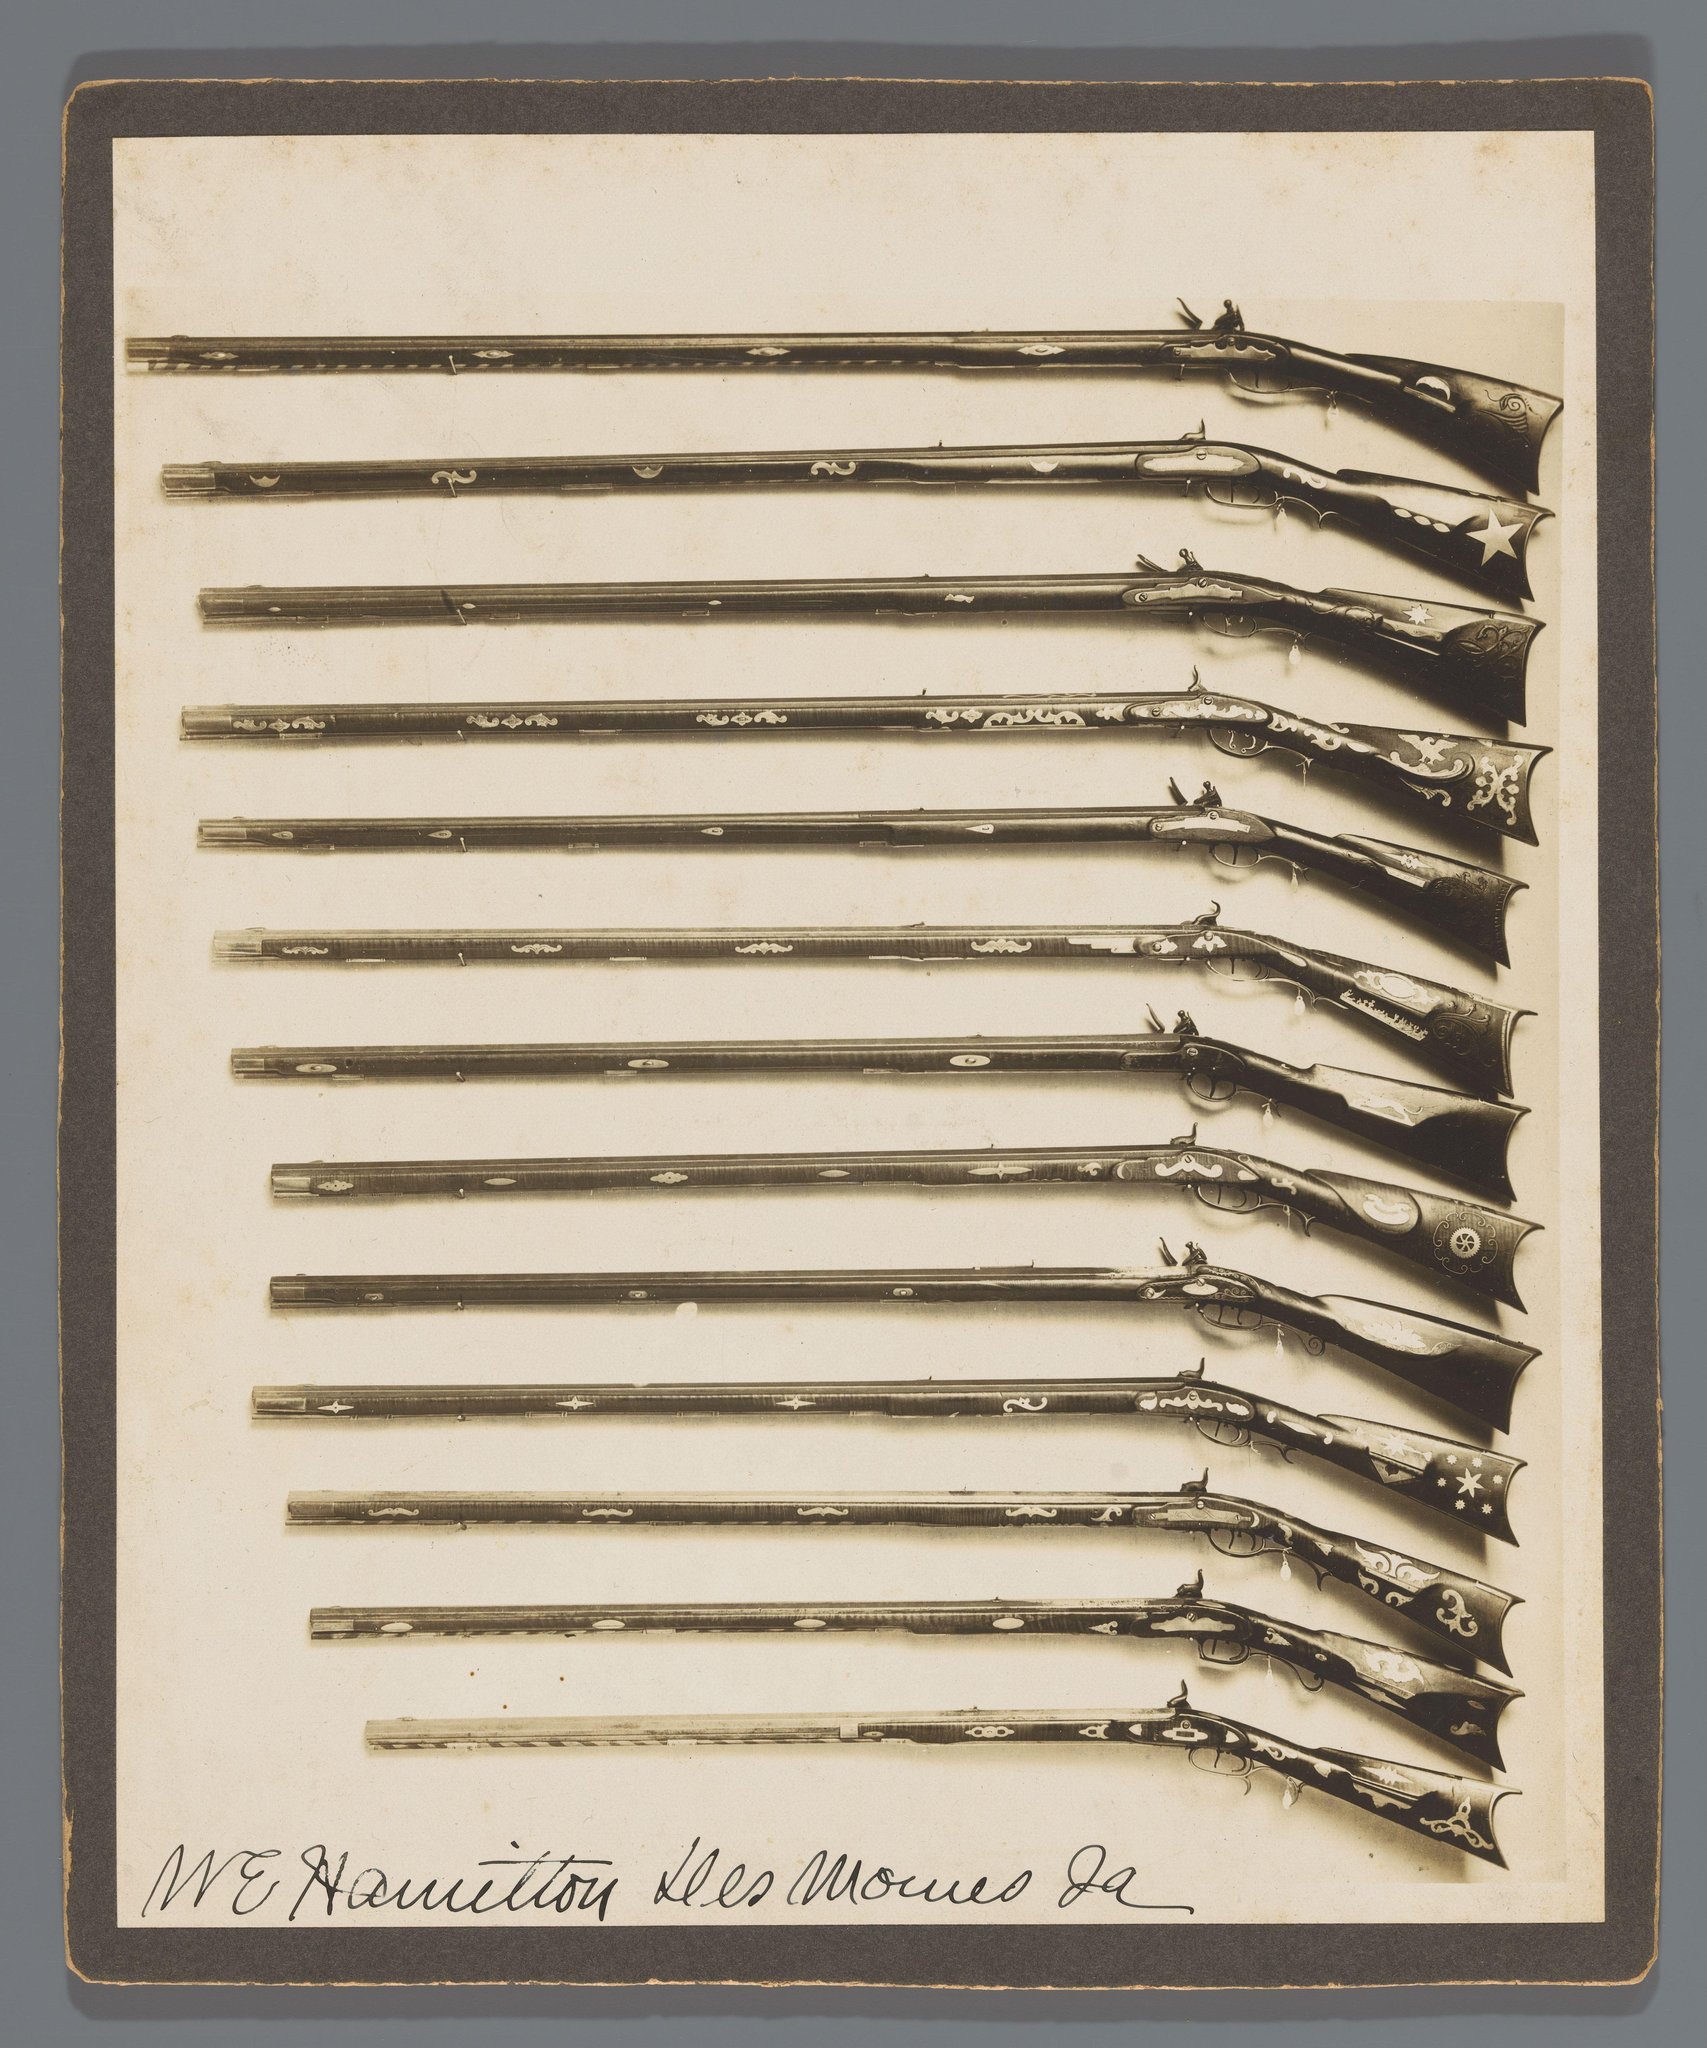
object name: photograph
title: Reclamefoto met dertien Kentucky Rifles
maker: Anonymous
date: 1900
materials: paper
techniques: gelatin silver print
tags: firearms: rifle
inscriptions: inscription: ‘Thirteen Kentucky Rifles belonging to W.E. Hamilton Collection,/ Des Moines, Iowa./ (...)/ These Guns are all in good working order. Nos. 6, 7 and 13 are nearly as perfect as new. If you know of any/ of this type for sale, please write me.’, inscription: ‘W.E. Hamilton Des Moines Ia’, inscription: ‘18-A, G.-53 [...]sh gun, B[...]’